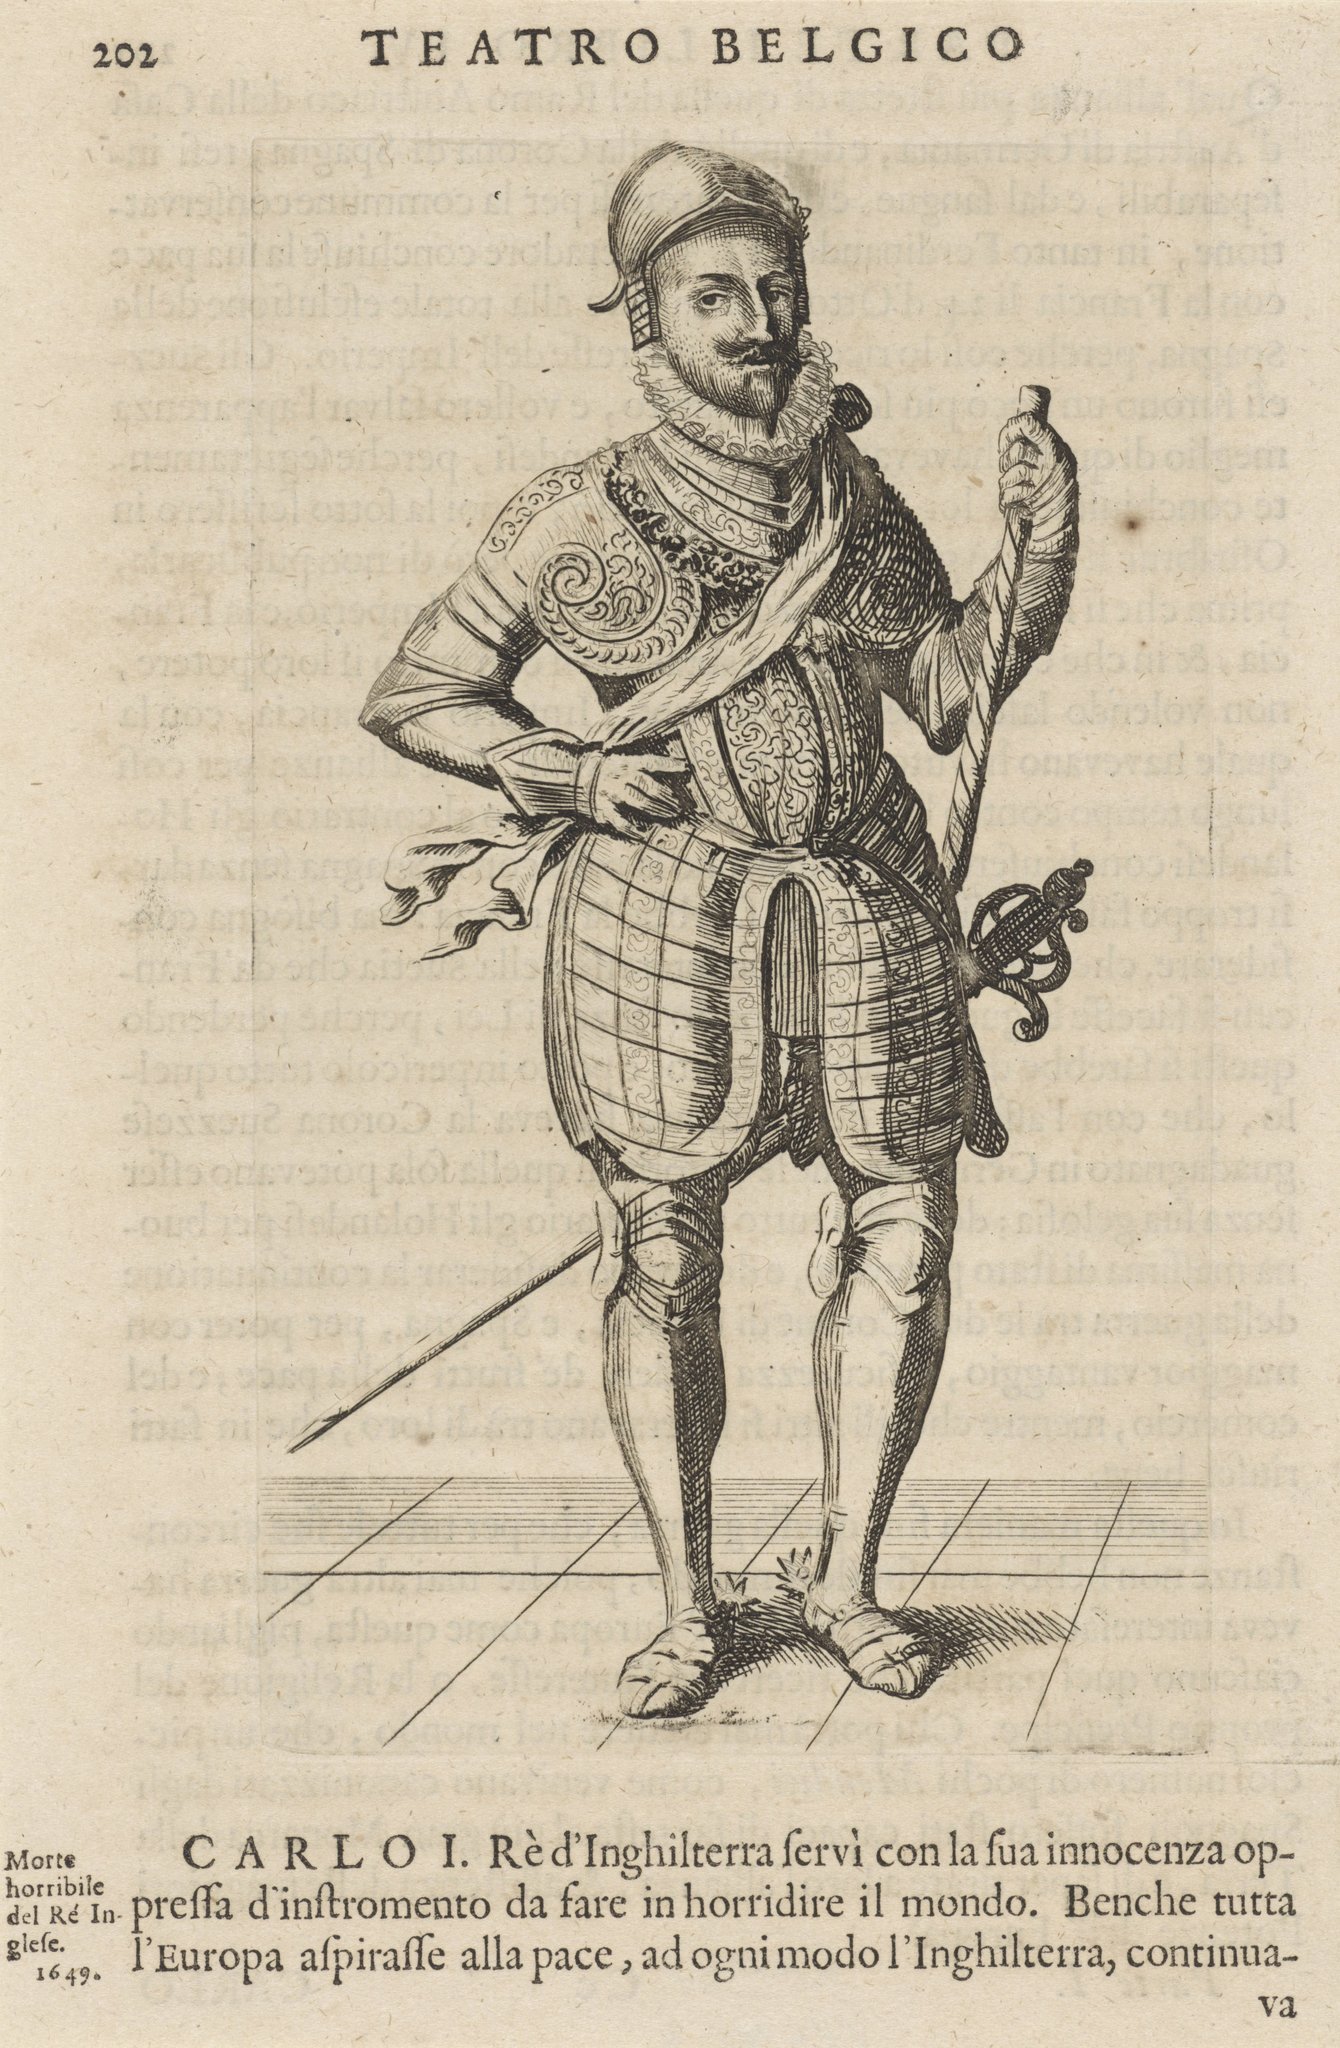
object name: print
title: Portret van Karel I, koning van Engeland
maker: Anonymous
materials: paper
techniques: etching, letterpress printing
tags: london, karel i (koning van engeland)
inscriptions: collector's mark: Lugt 2228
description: Prent komt voor op p. 202 in: Gregorio Leti. Teatro Belgico, o Vero ritratti historici, chronologici, politici, e geografici, delle sette Provincie Unite. Amsterdam: Willem de Jonge, 1690.